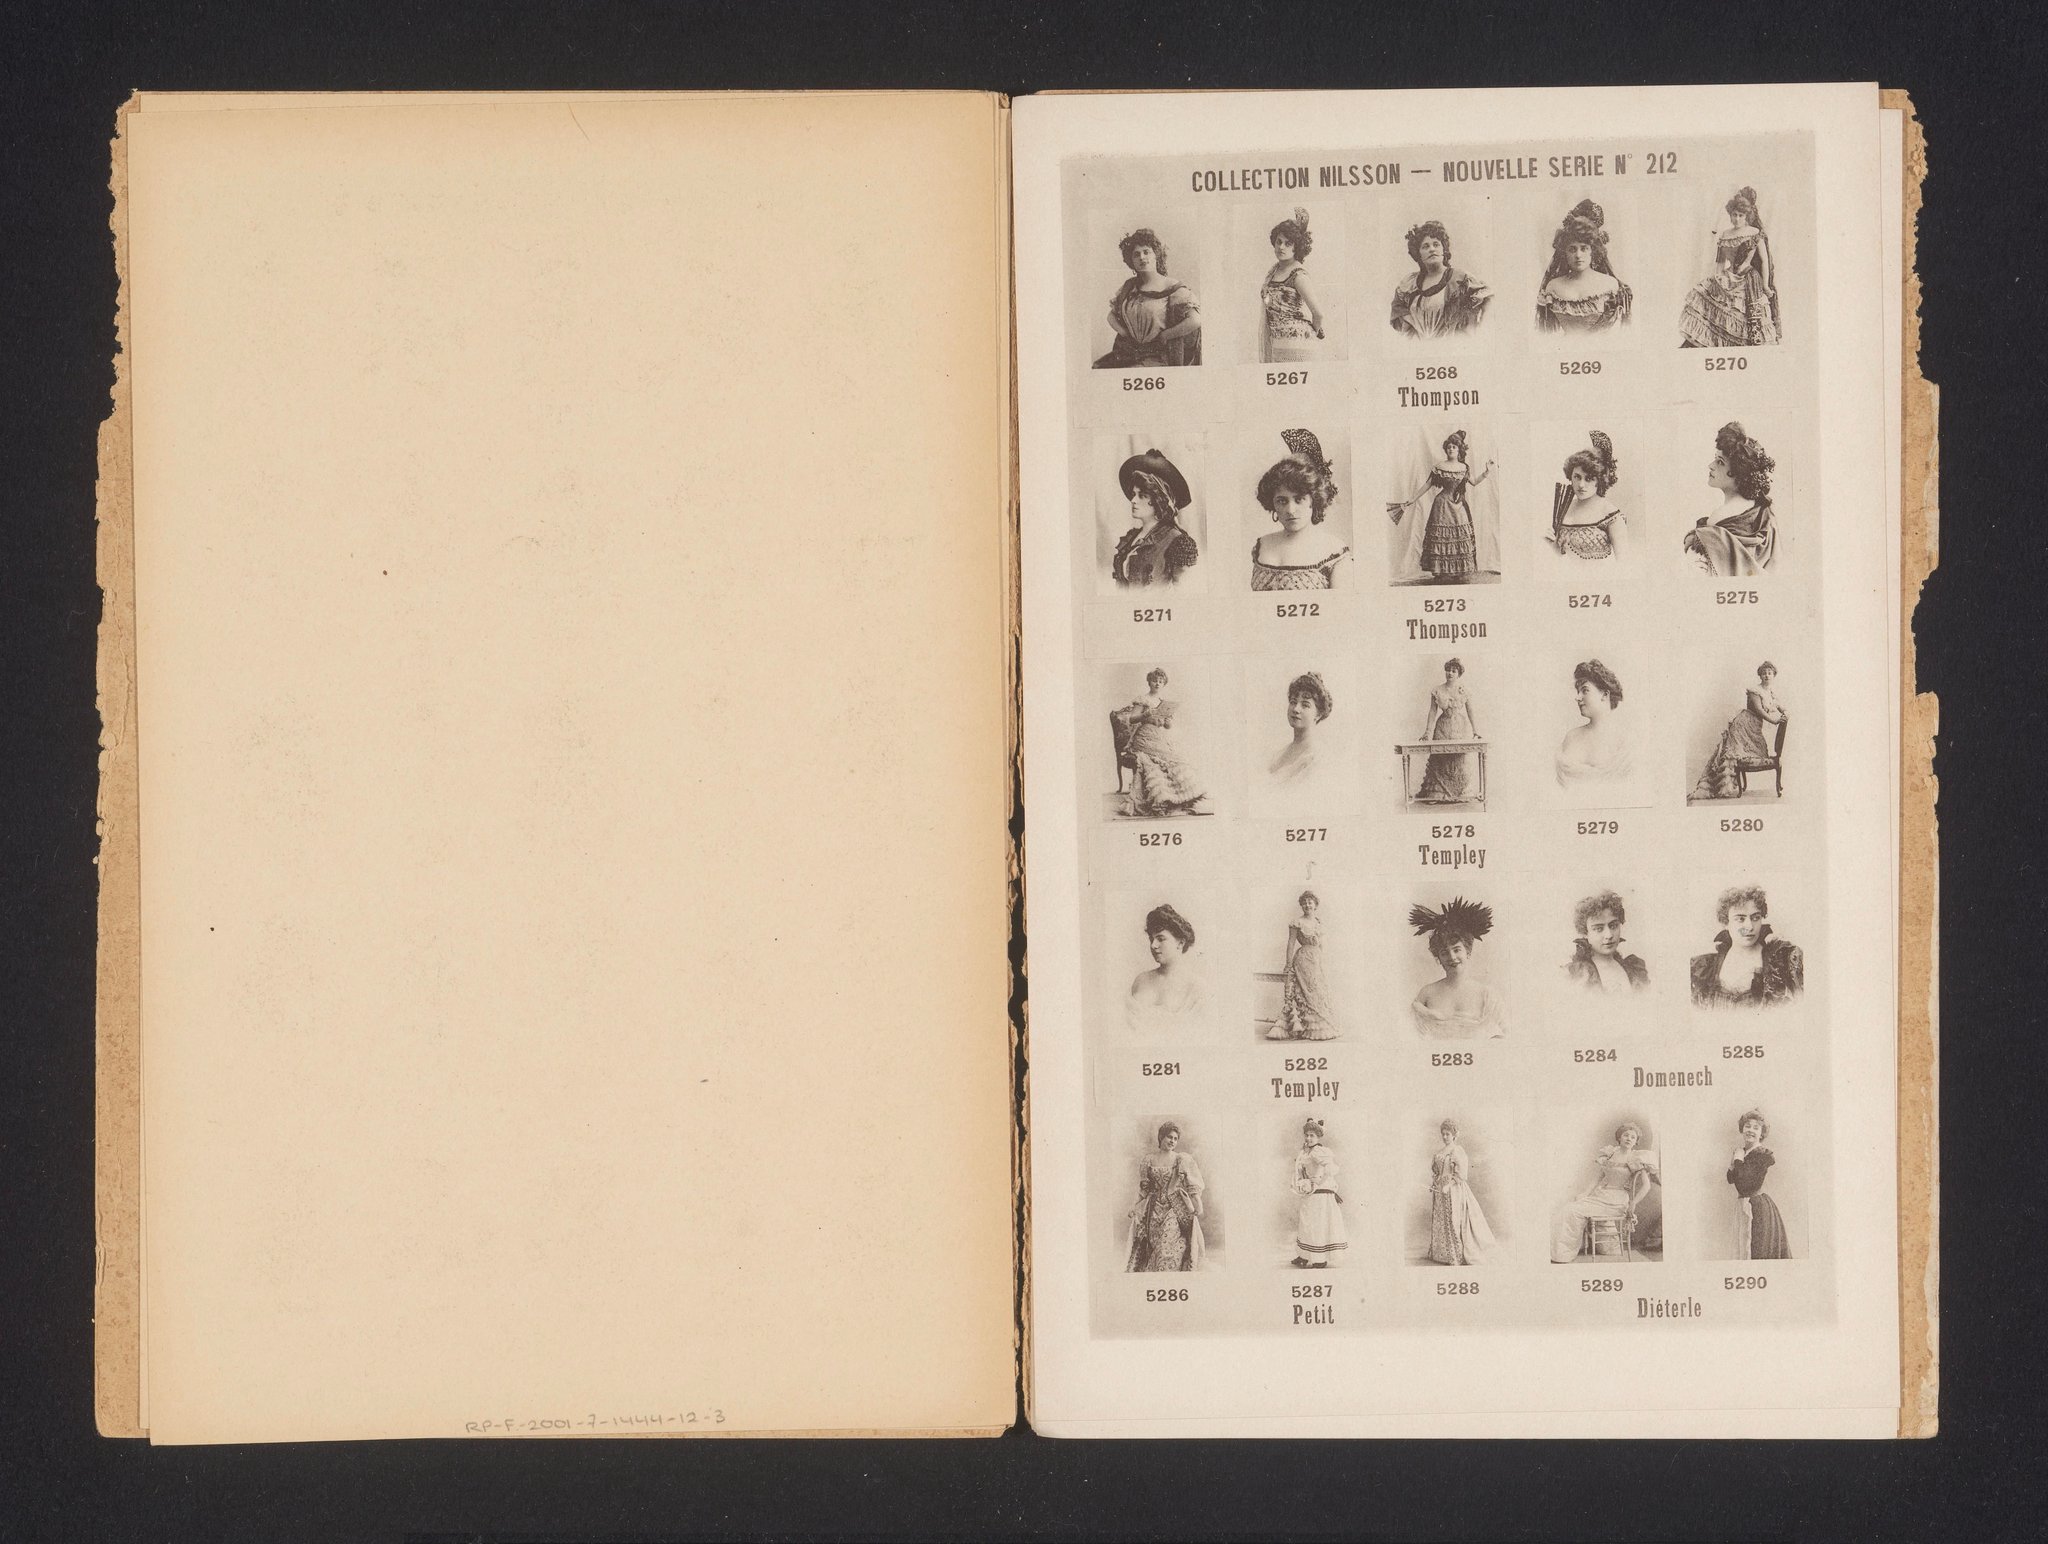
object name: page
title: 25 portretten van Thompson, Templey, Domenech, Valentine Petit en Diéterle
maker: Anonymous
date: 1894-1899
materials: paper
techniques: photograph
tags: historical persons - bb - woman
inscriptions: number: ‘No 212’